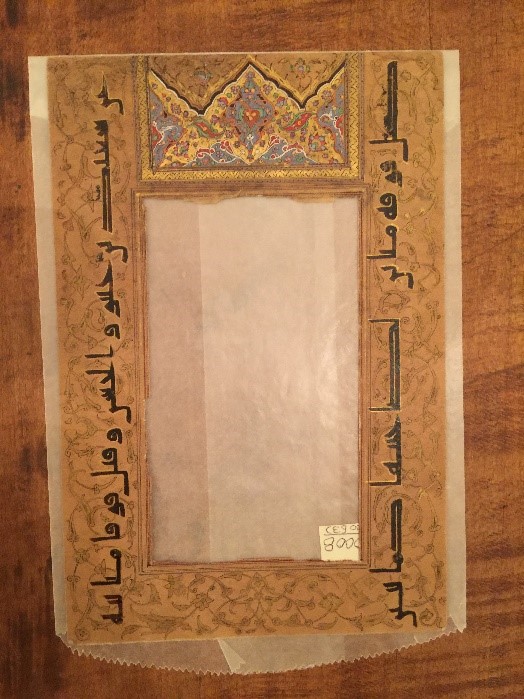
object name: folio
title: Decorated Folio with Kufic Inscription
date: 1701-1900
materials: gold, ink, paper, watercolor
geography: iran